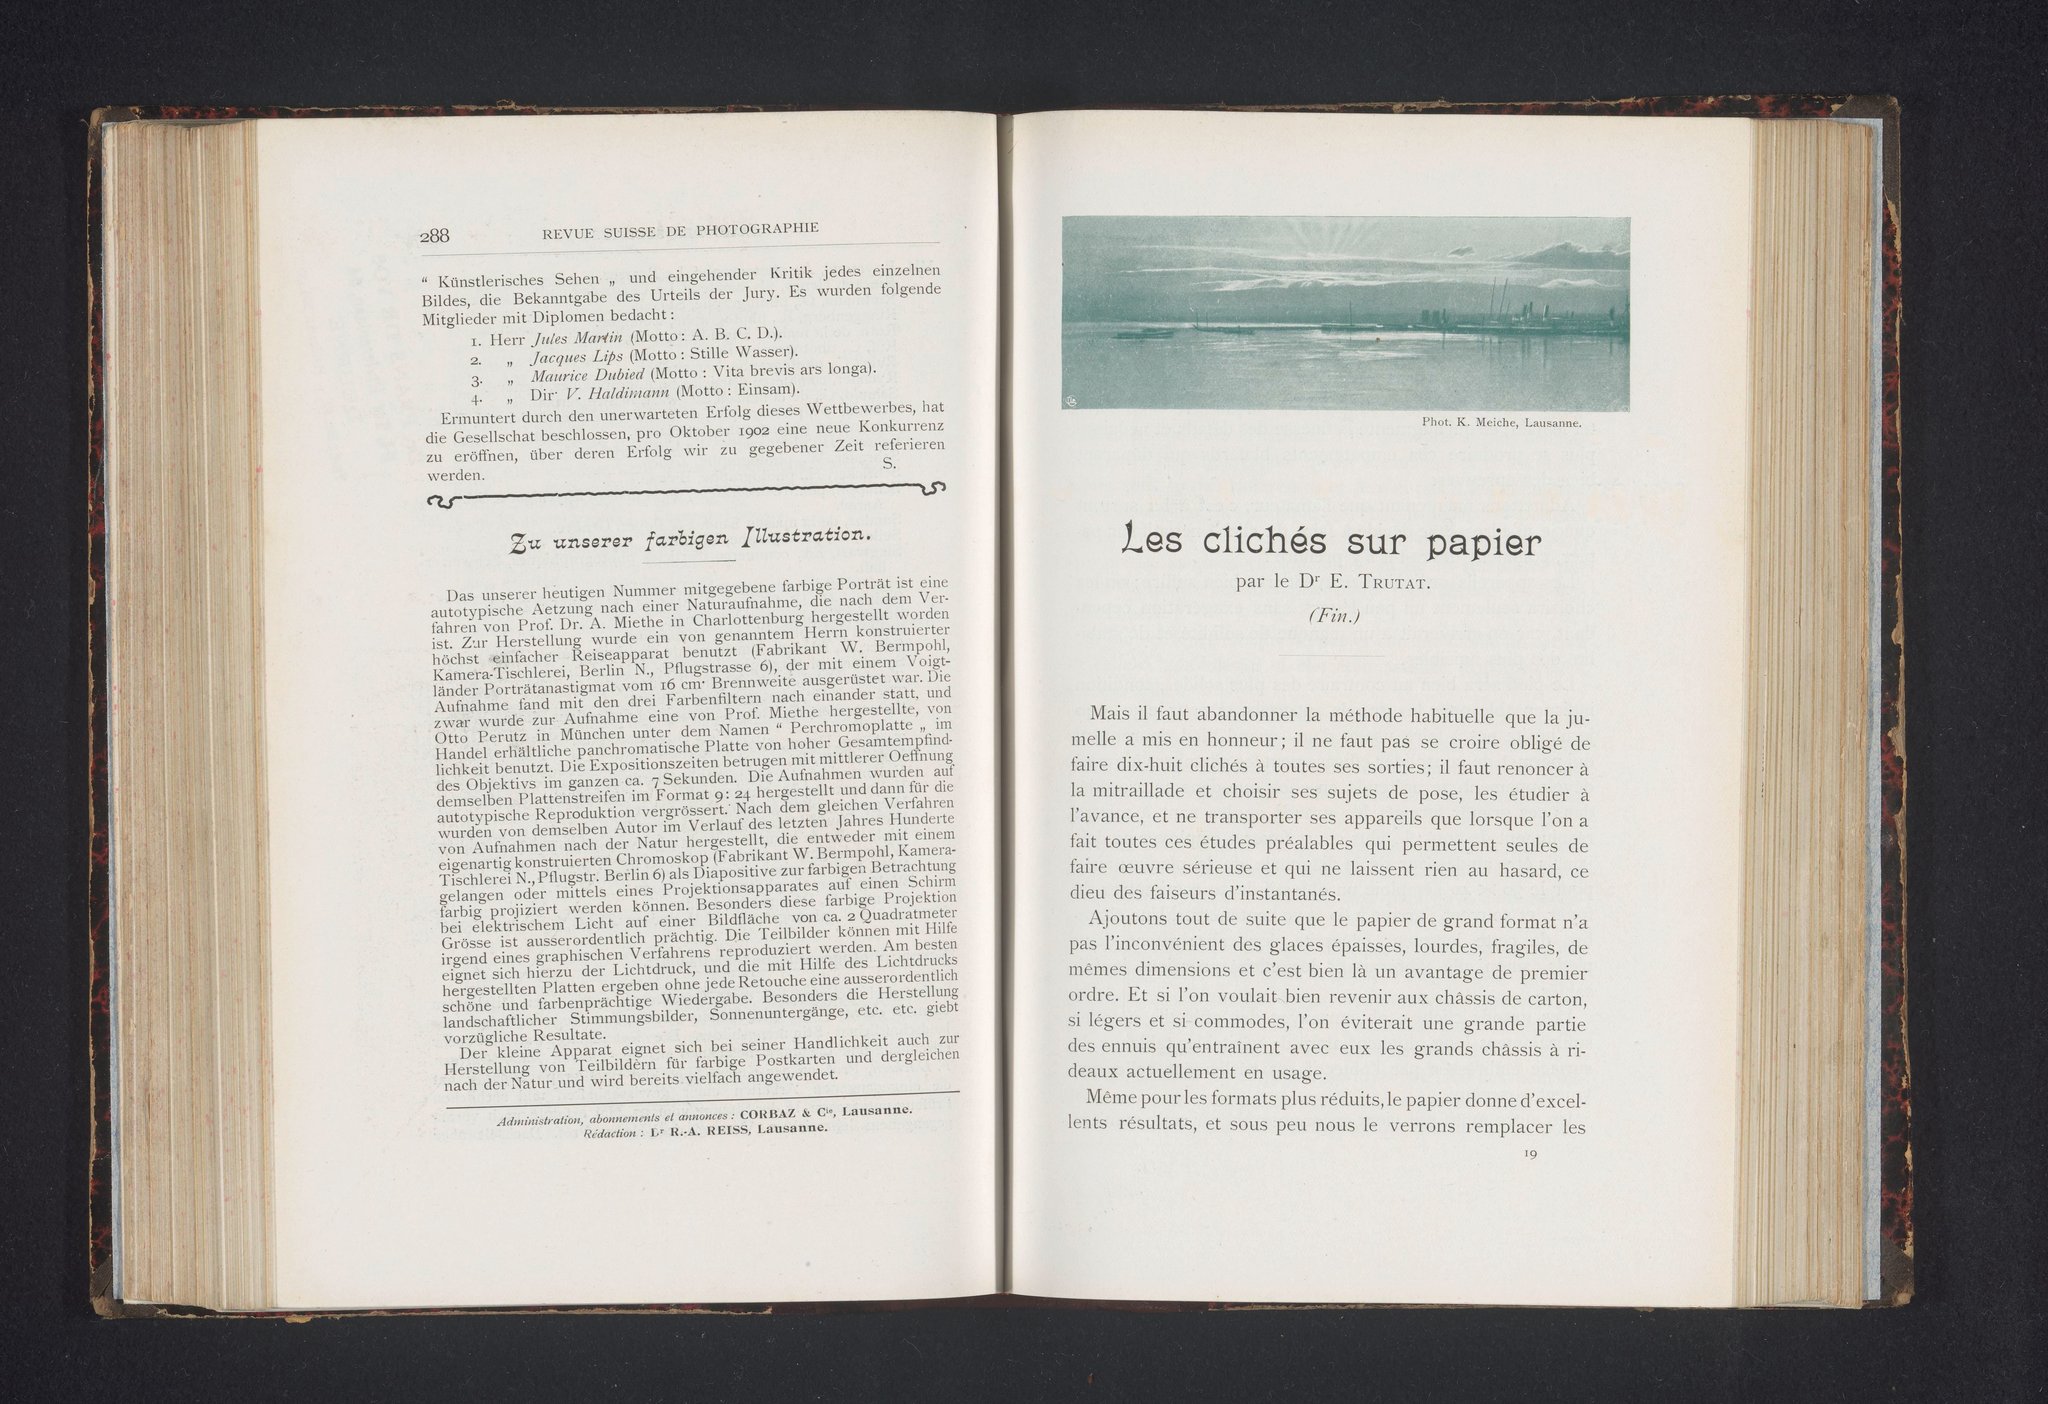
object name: photomechanical print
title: Waterlandschap met een pier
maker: k. meiche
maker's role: fotograaf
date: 1897-1902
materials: paper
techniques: autotype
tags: landscapes with waters, waterscapes, seascapes (in the temperate zone), pier, quay, wharf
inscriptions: inscription: ‘Phot. Minner (Maison Fueslin-Rigaud) Genève’, monogram: ‘C. Cie’